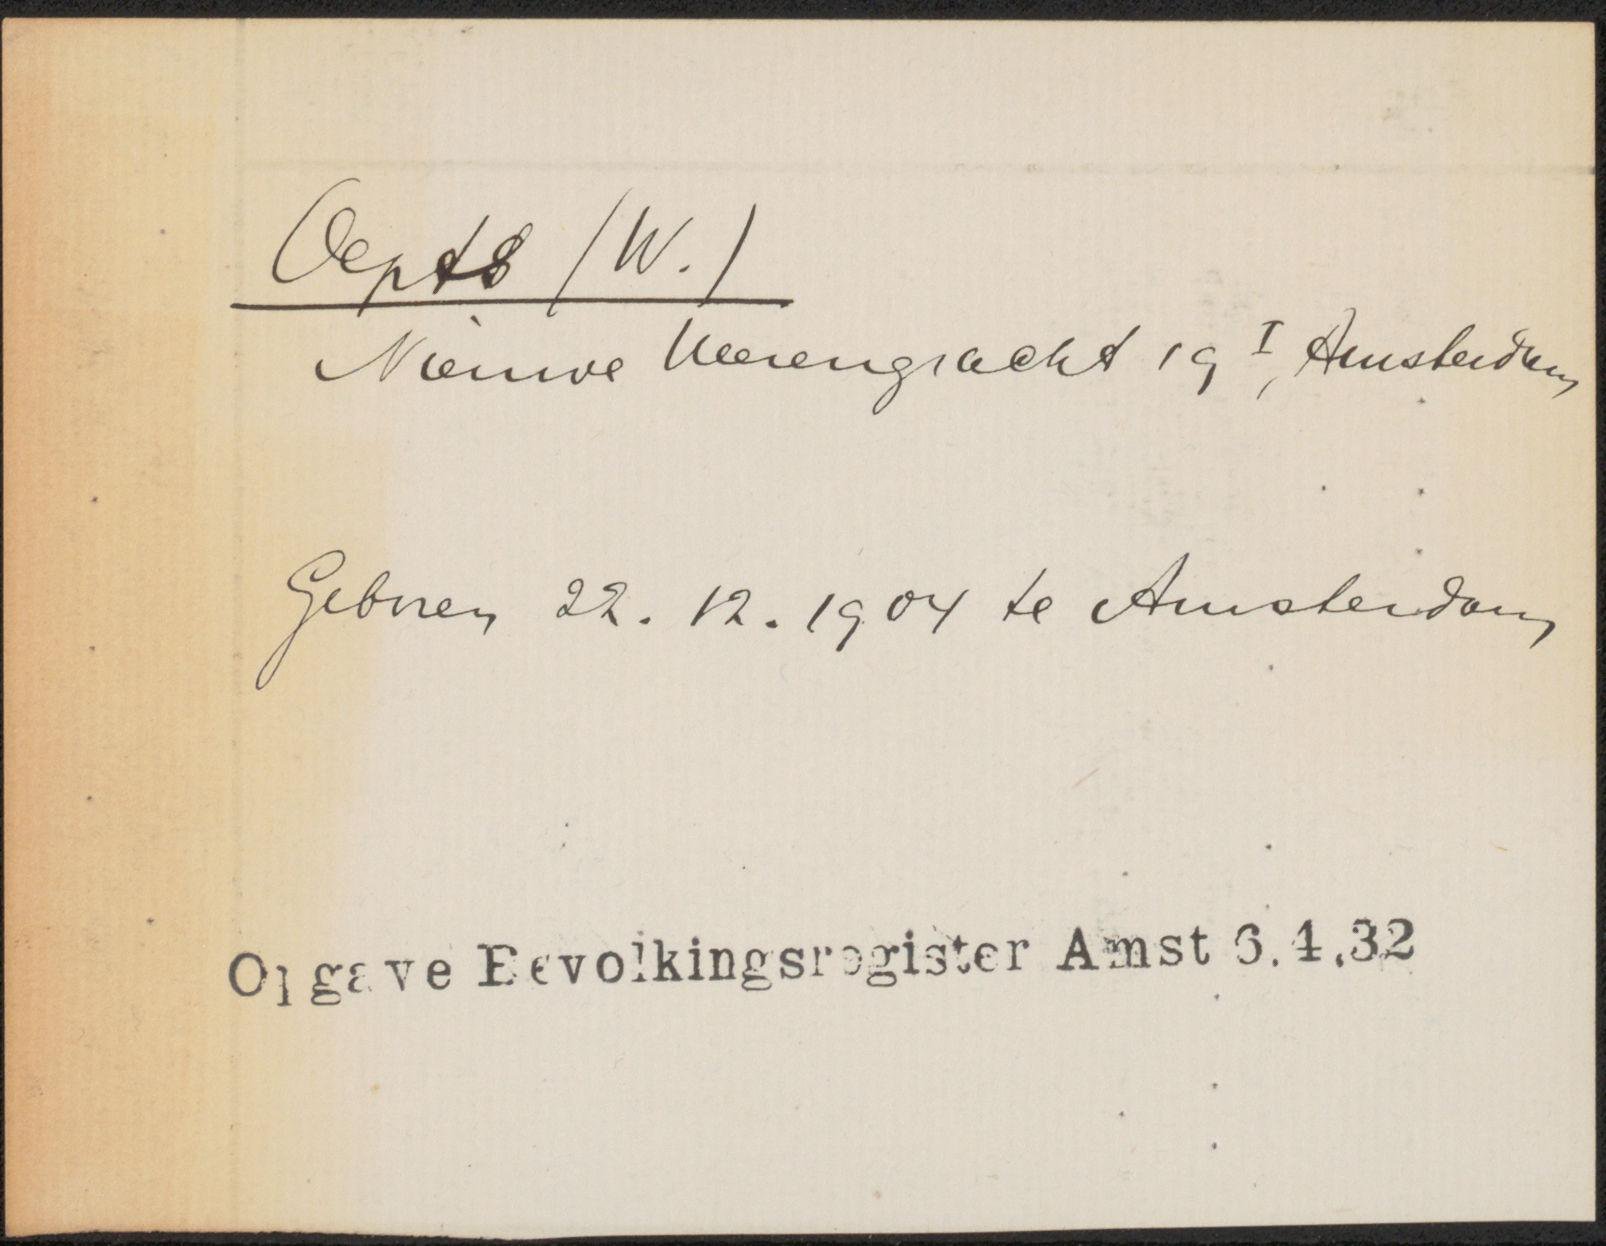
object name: aantekening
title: Aantekening betreffende Wim Oepts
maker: Anonymous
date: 1932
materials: ink, paper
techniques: pen, writing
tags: amsterdam, paris, print maker, draughtsman, wim oepts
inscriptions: stamp: ‘Opgave Bevolkingsregister Amst 6.4.32’